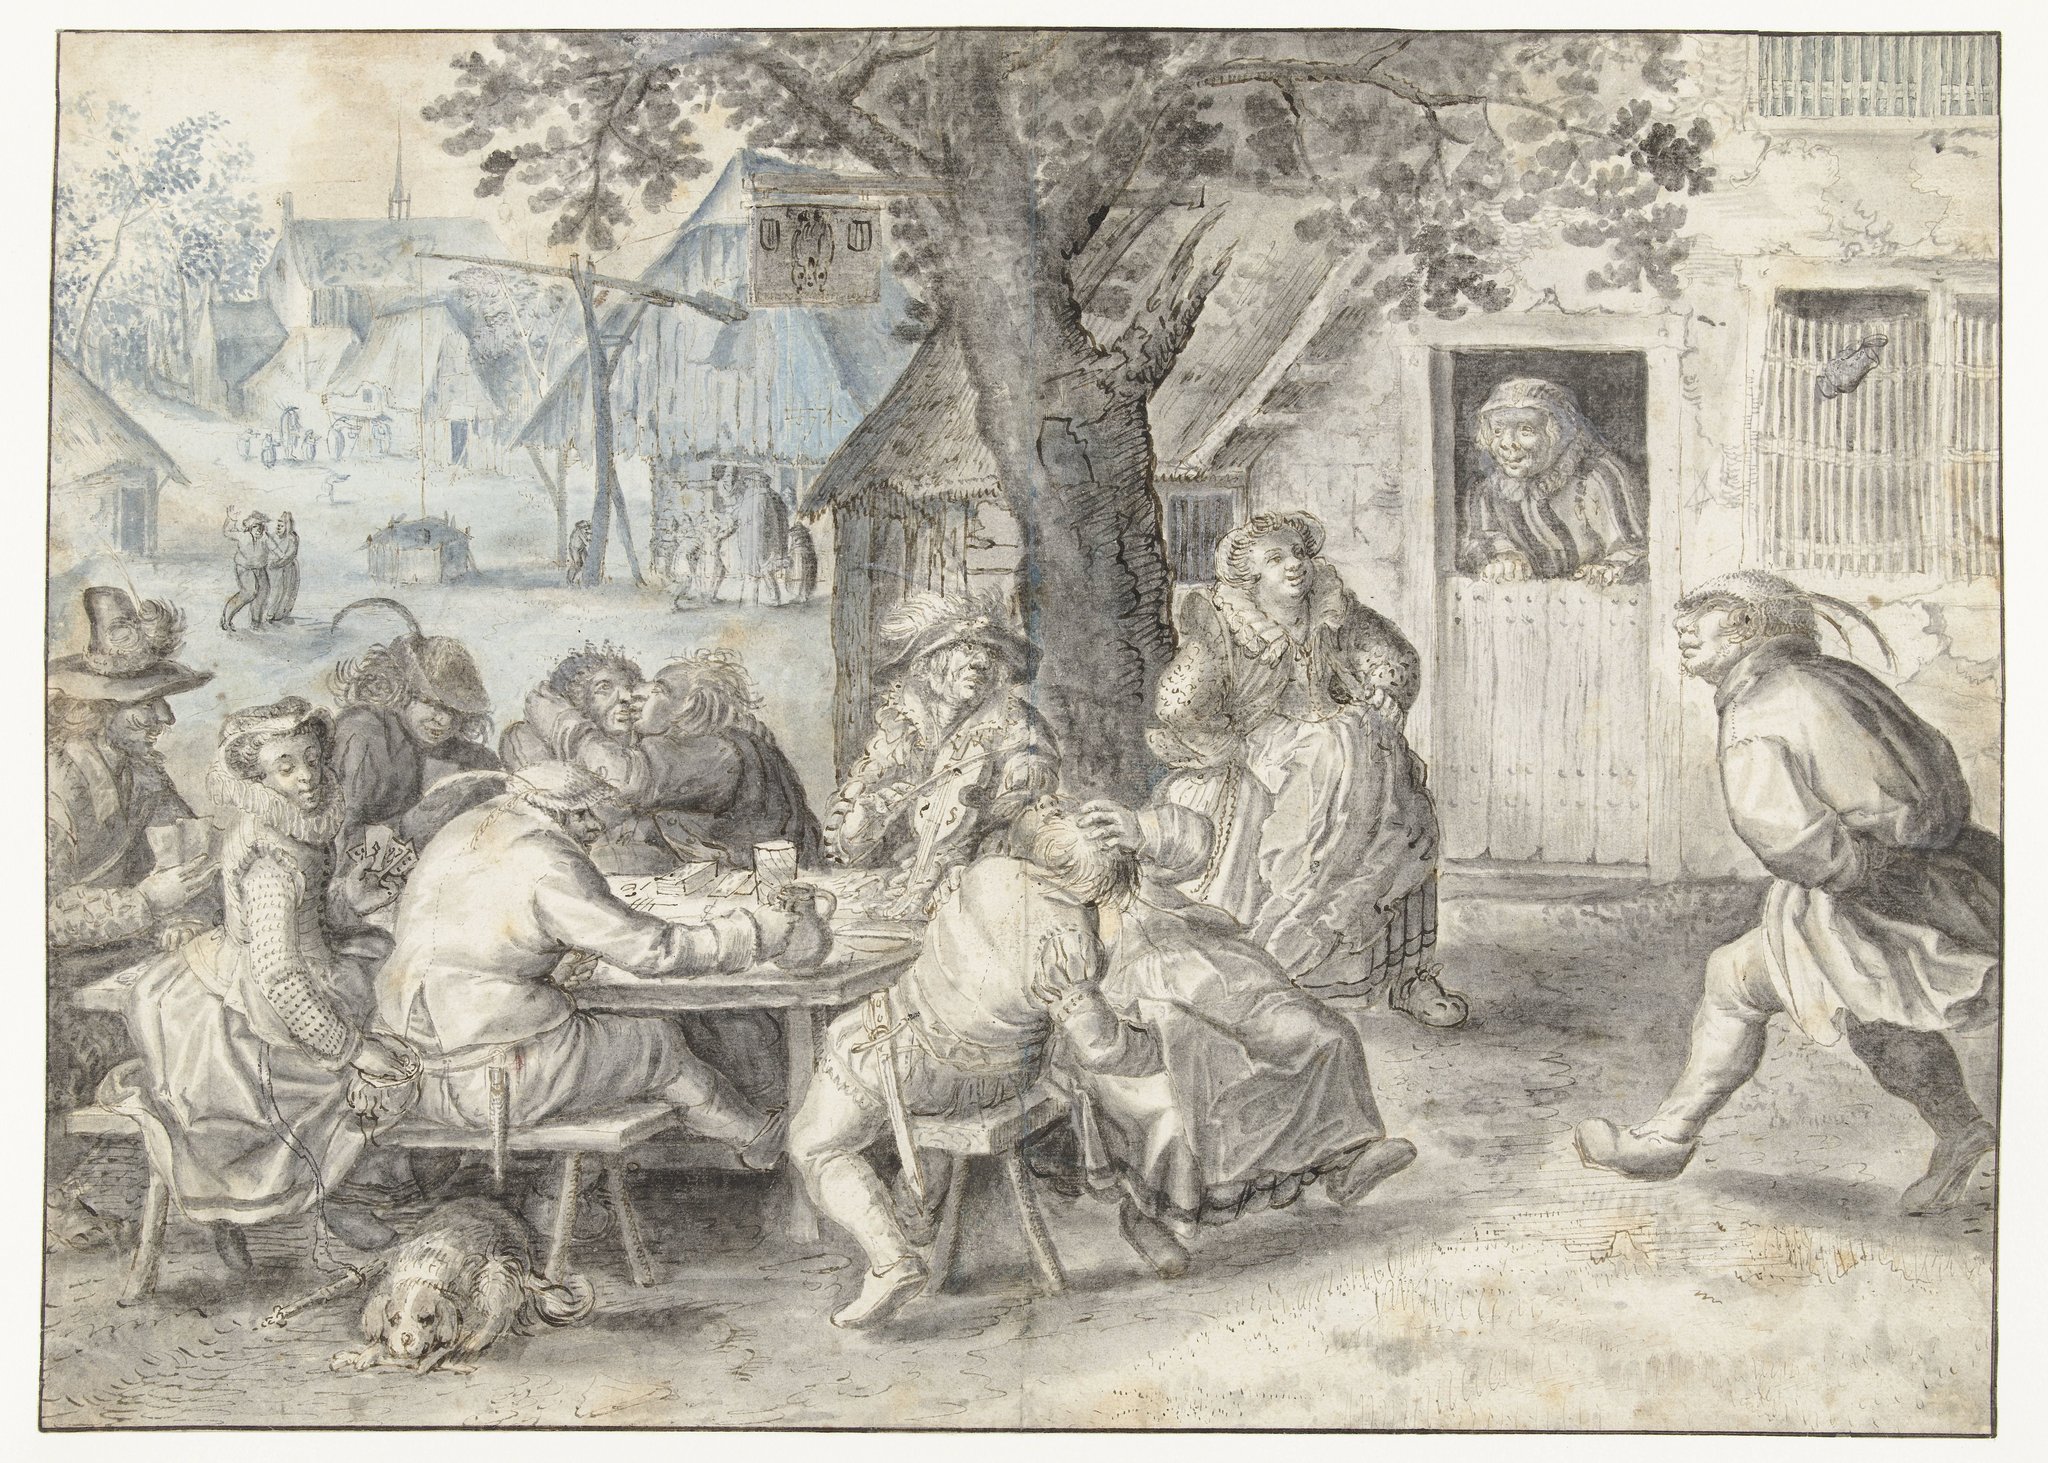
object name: drawing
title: Festive Peasants, Soldiers, and Harlots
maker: david vinckboons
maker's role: draughtsman, painter, print maker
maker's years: 1576-1629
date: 1603-1608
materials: ink, paper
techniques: brush, pen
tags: (lovers) kissing each other, fight between farmers and soldiers, soldiers and civilians, pavement, terrace in front of inn or restaurant, prostitution, drinking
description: While a soldier is amorously engaged, a peasant pinches his jug of beer. Meanwhile a harlot robs the peasant of his money, unaware that a soldier is cheating by looking at her hand of cards. Vinckboons made the drawing on the eve of the Twelve Year Truce (1609-1621) marking the cease-fire between Spain and the Northern Netherlands. In the seeming reconciliation, he perceives the seeds of new conflicts in the future.